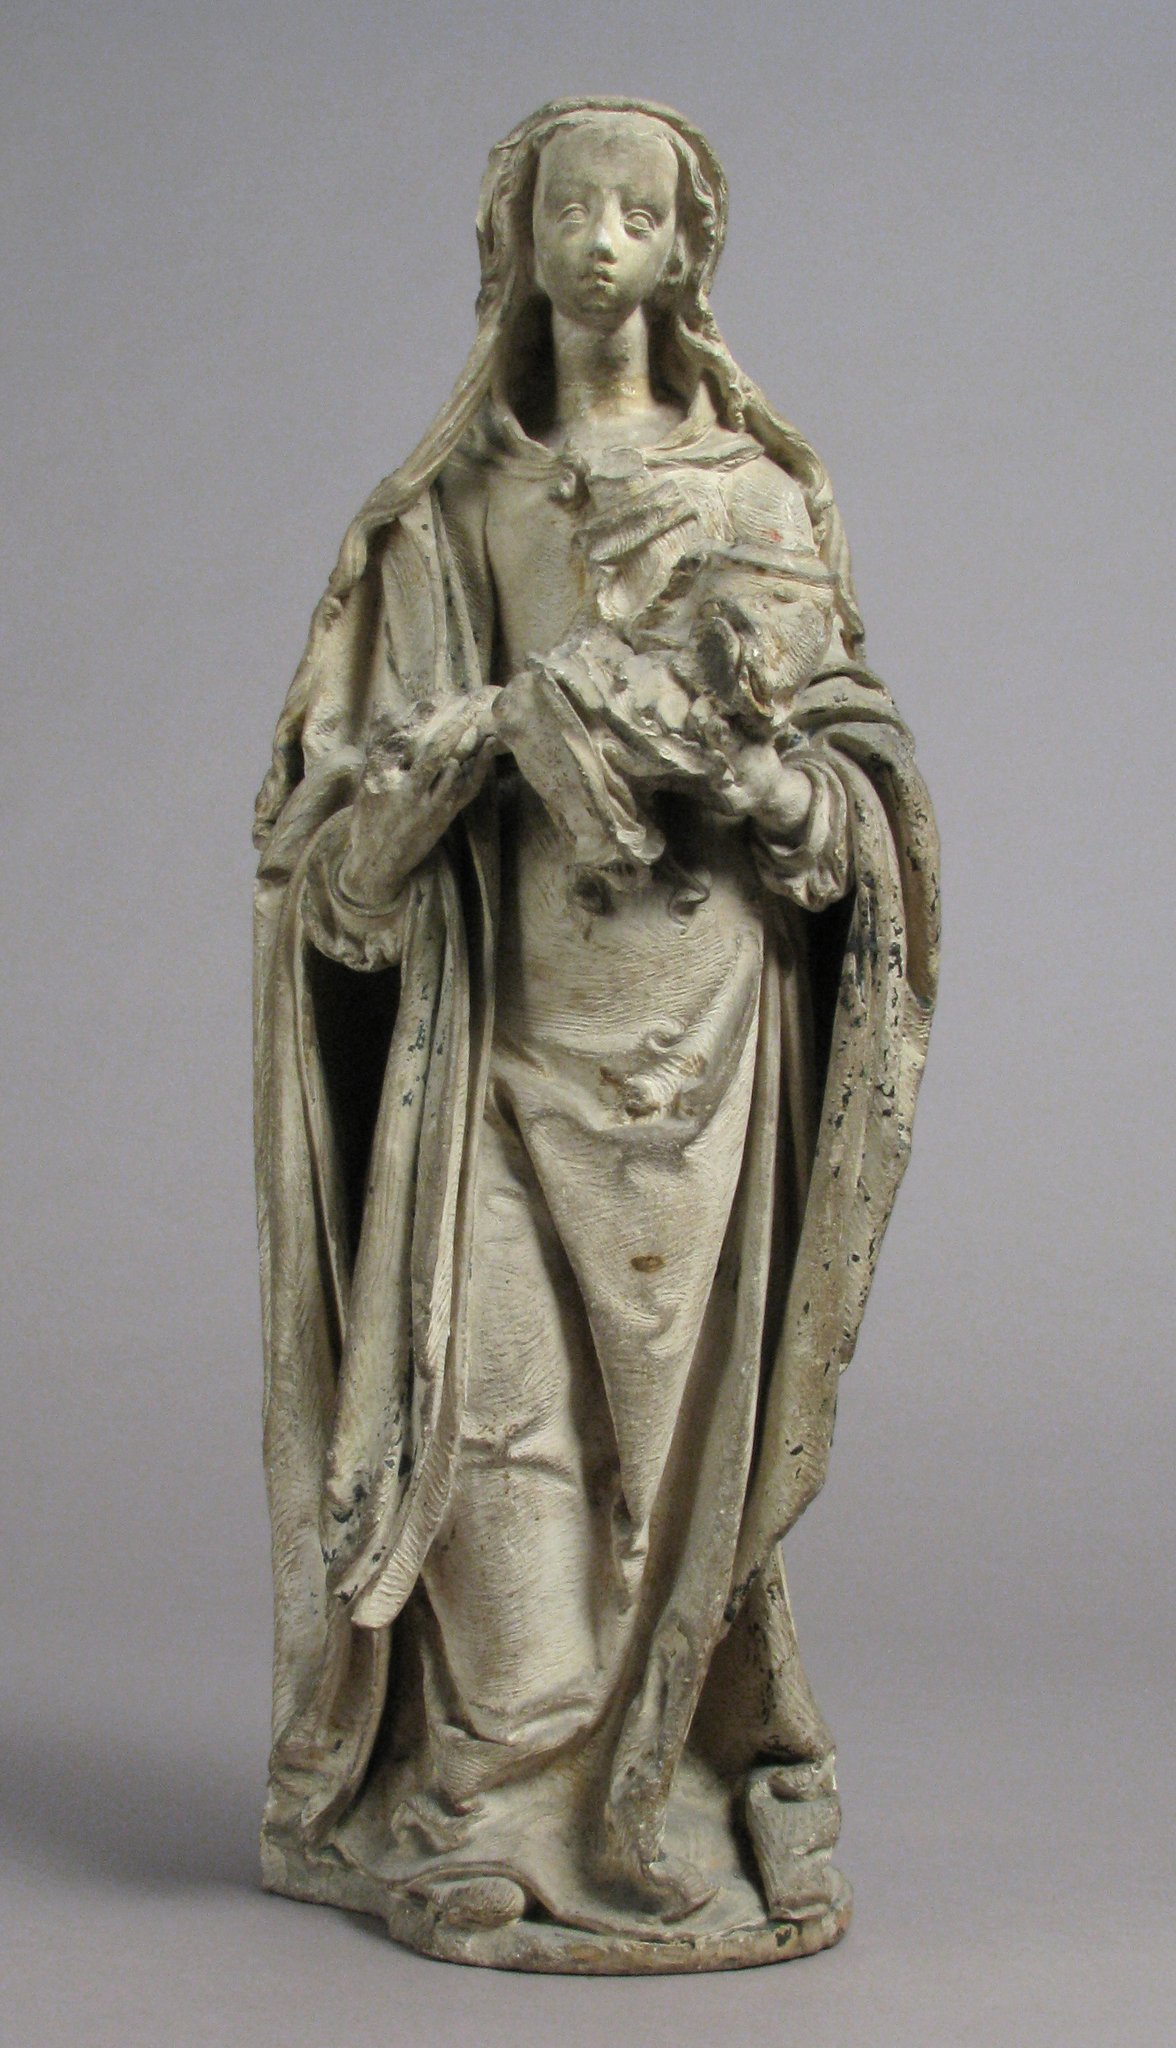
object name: statuette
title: Virgin and Child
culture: french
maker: atelier of the juliots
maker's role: artist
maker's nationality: french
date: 1550-1560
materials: limestone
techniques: polychromy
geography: troyes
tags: christ,virgin mary